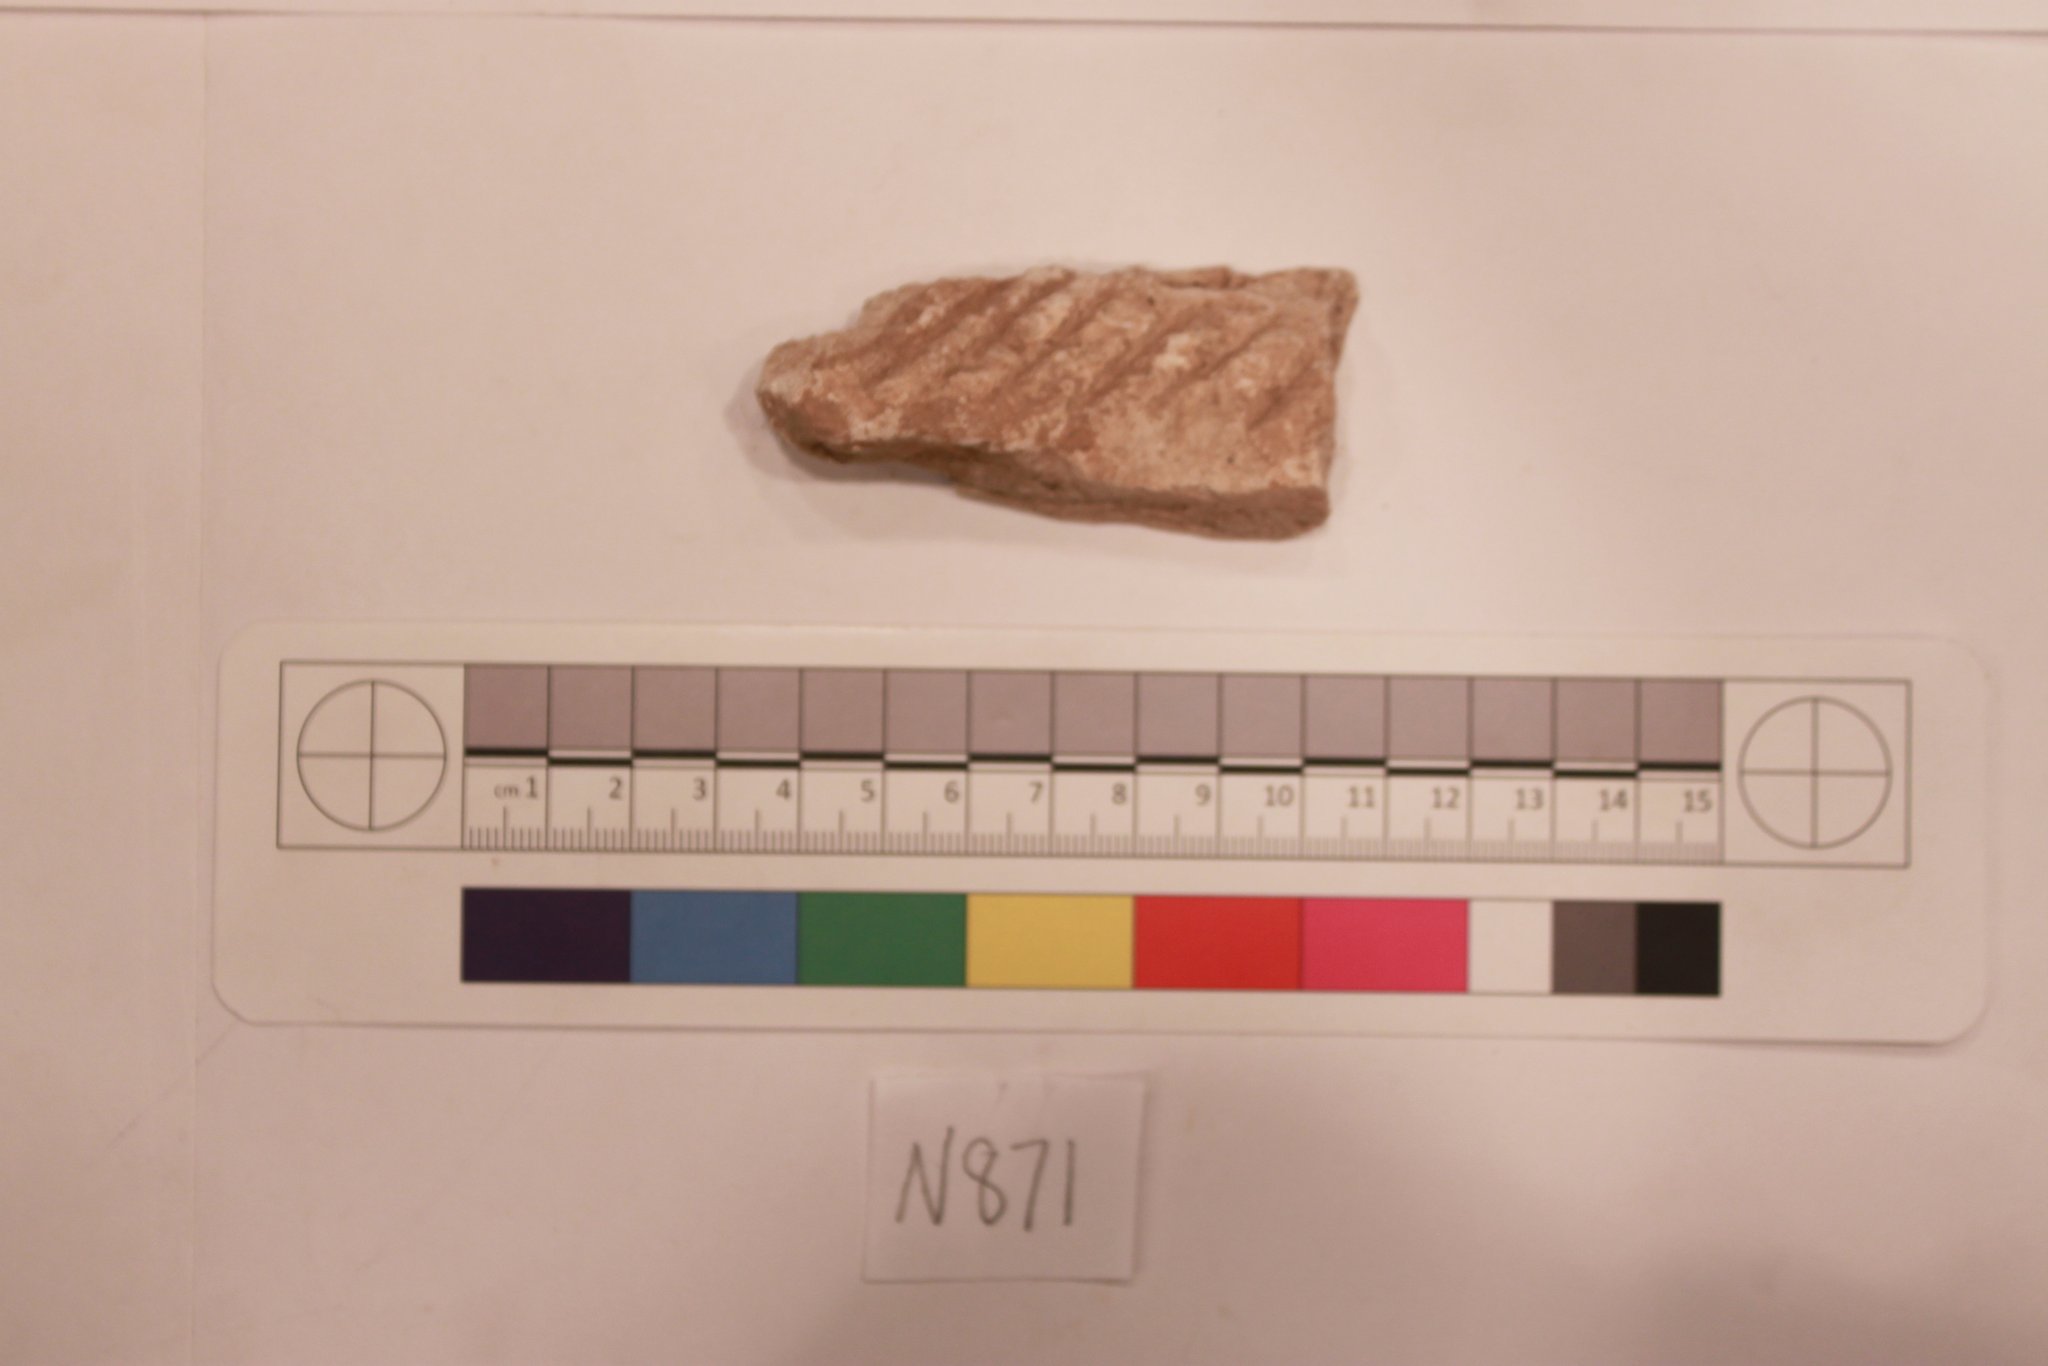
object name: fragment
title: Stucco Fragment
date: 701-1200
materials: plaster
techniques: carving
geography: iran